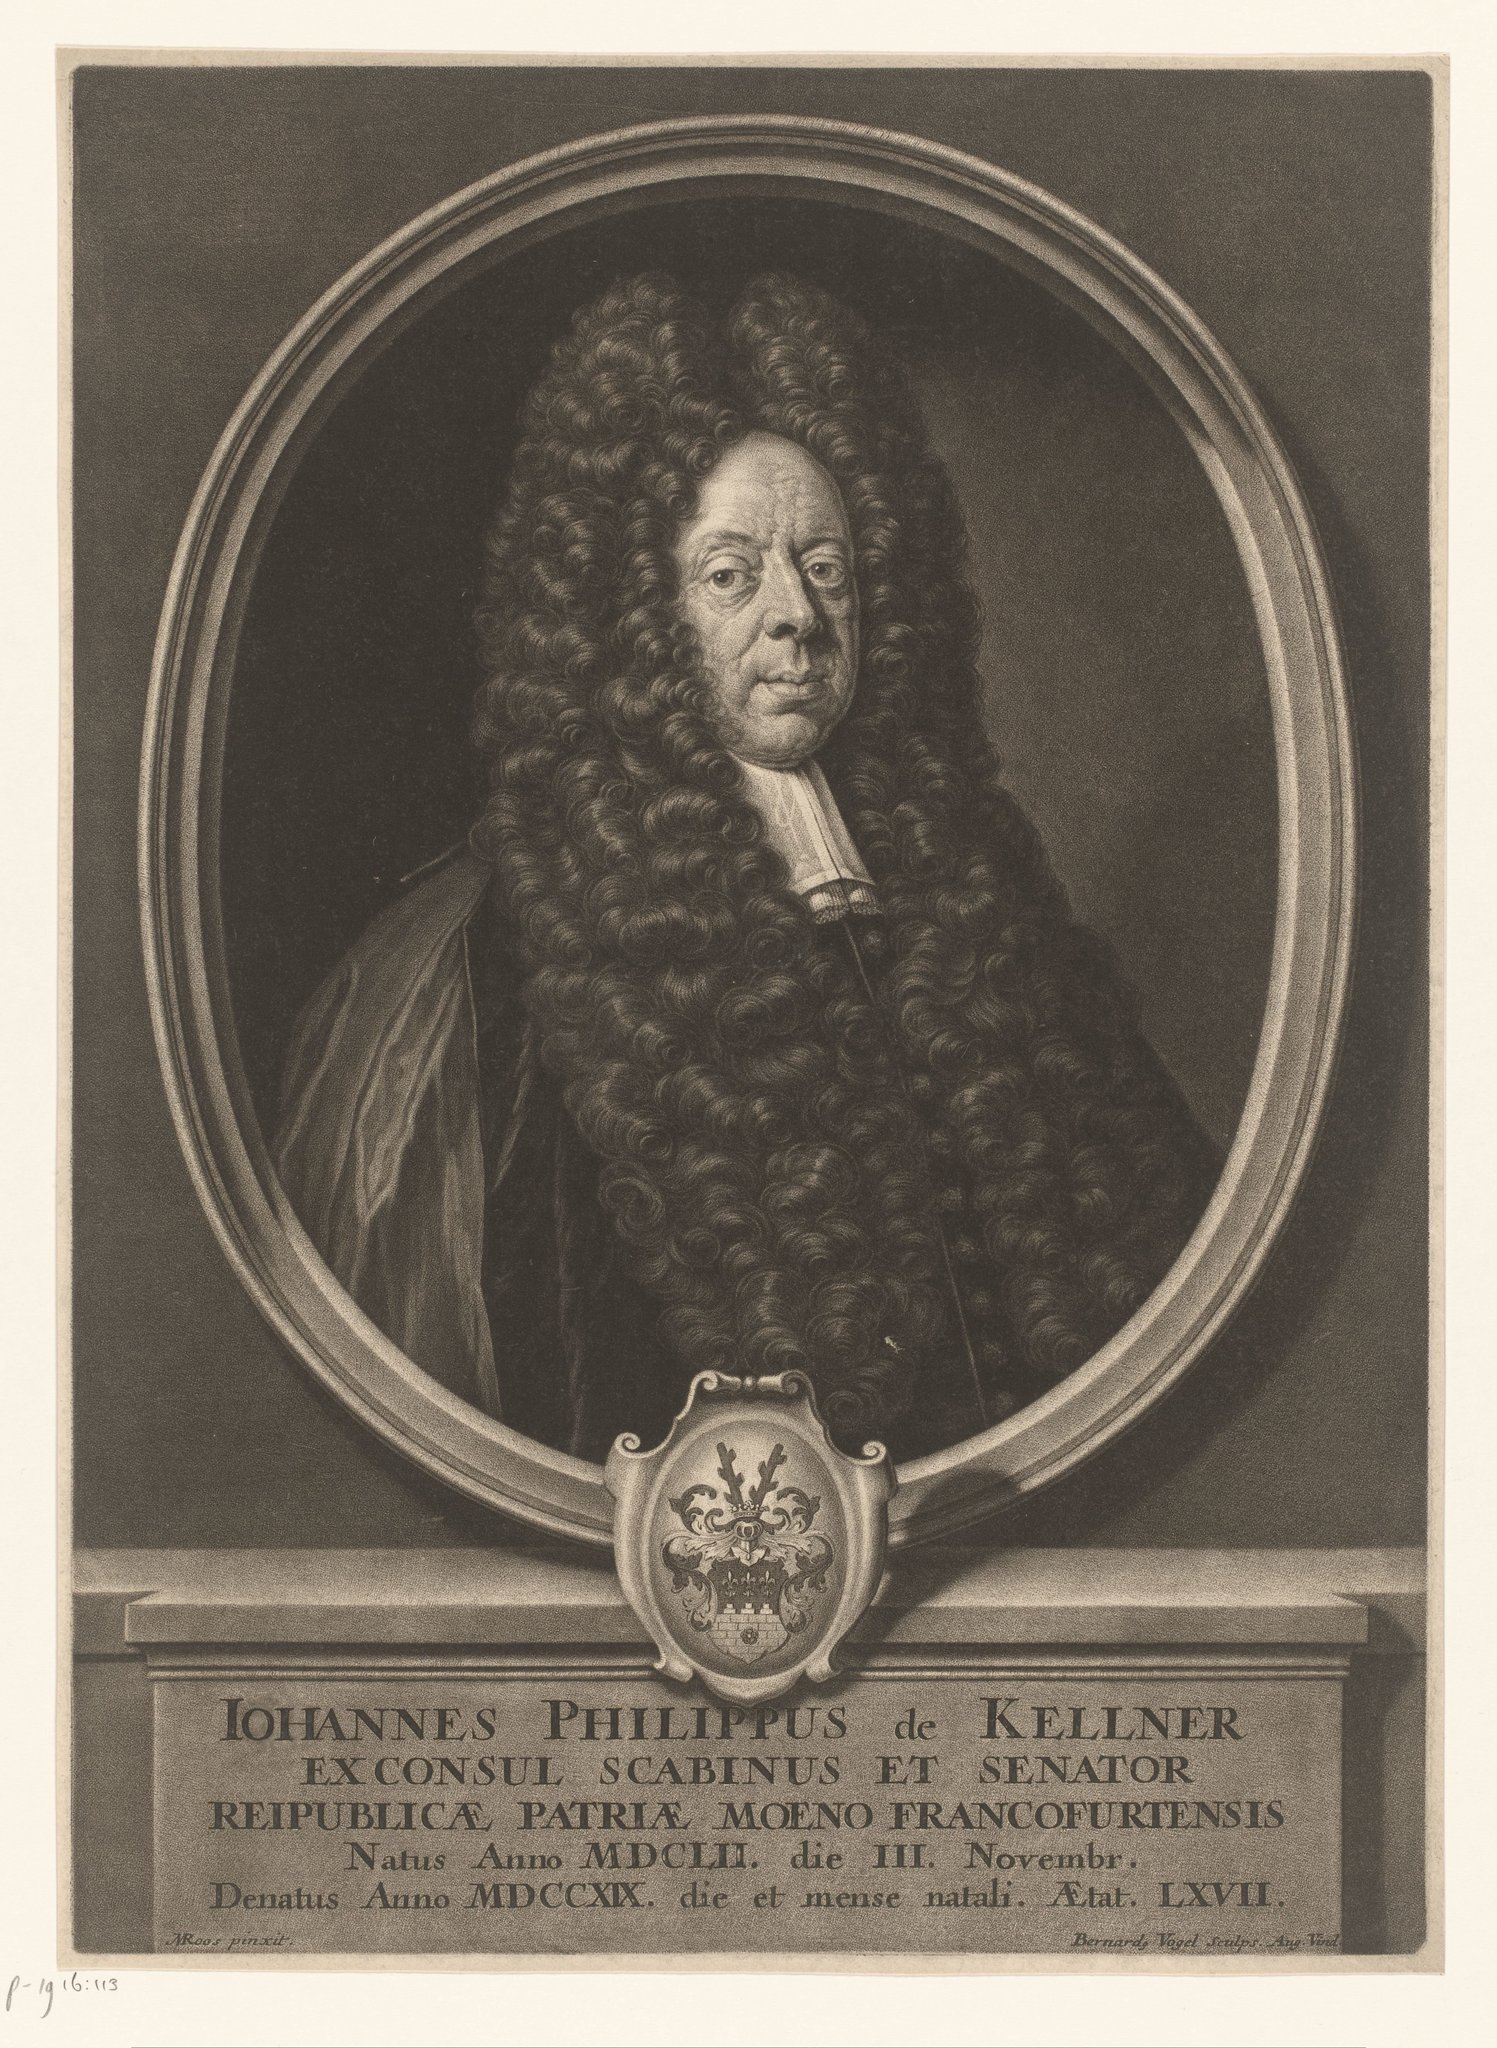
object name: print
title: Portret van Johann Philipp Kellner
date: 1719-1737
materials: paper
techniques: mezzotint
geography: augsburg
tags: mayor, historical persons, armorial bearing, heraldry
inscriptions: collector's mark: Lugt 2228